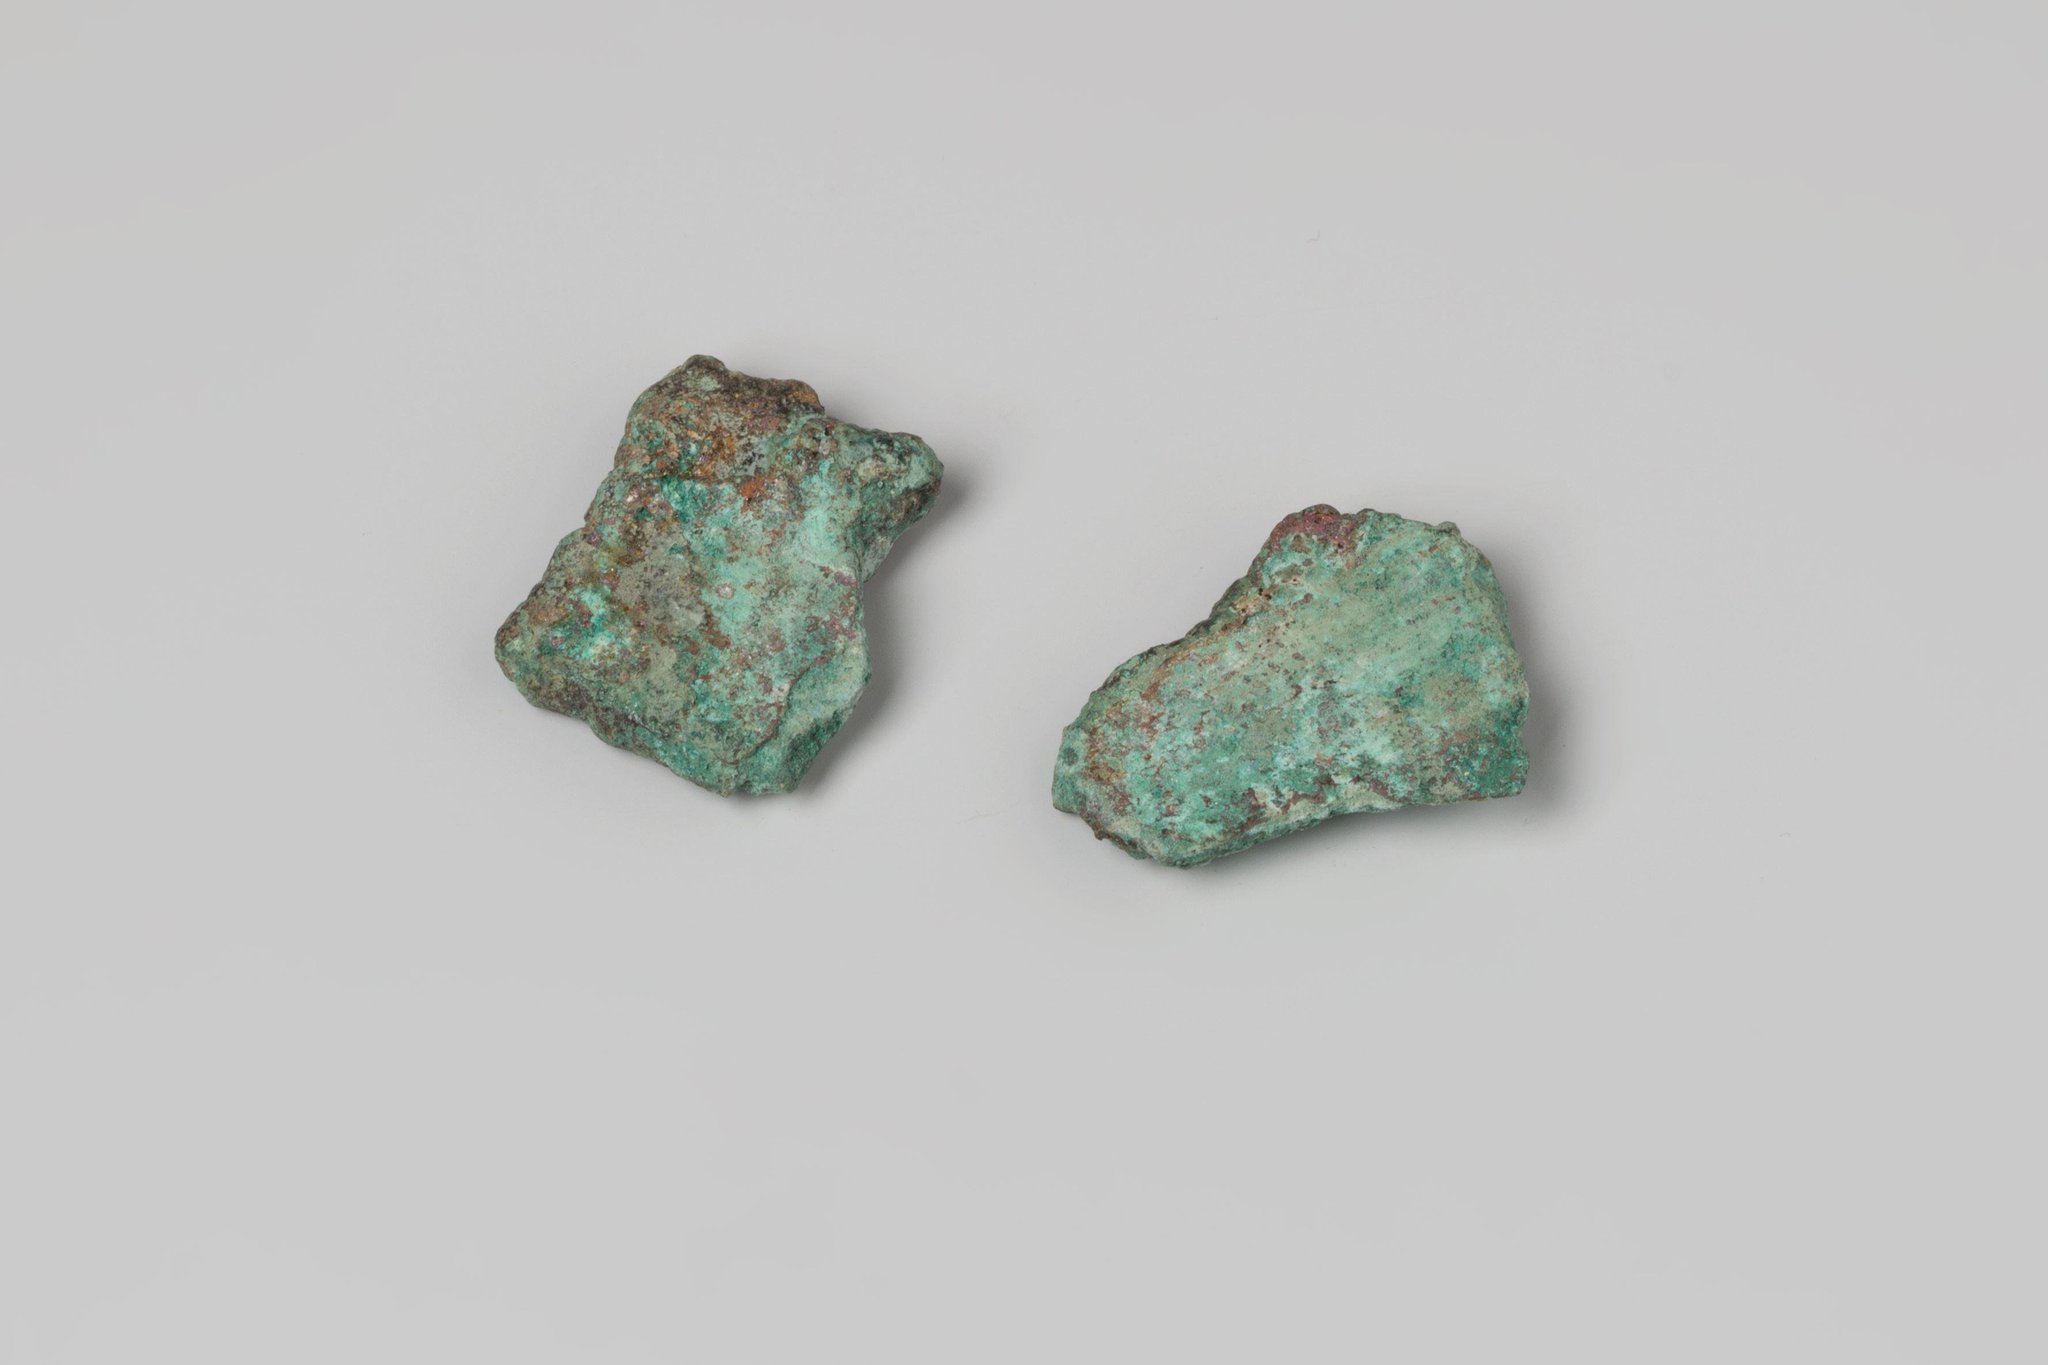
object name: fragment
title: Fragmenten koper uit het wrak van de Oost-Indiëvaarder Hollandia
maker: Anonymous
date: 1700-1743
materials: copper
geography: netherlands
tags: verenigde oostindische compagnie, hollandia (schip), annet